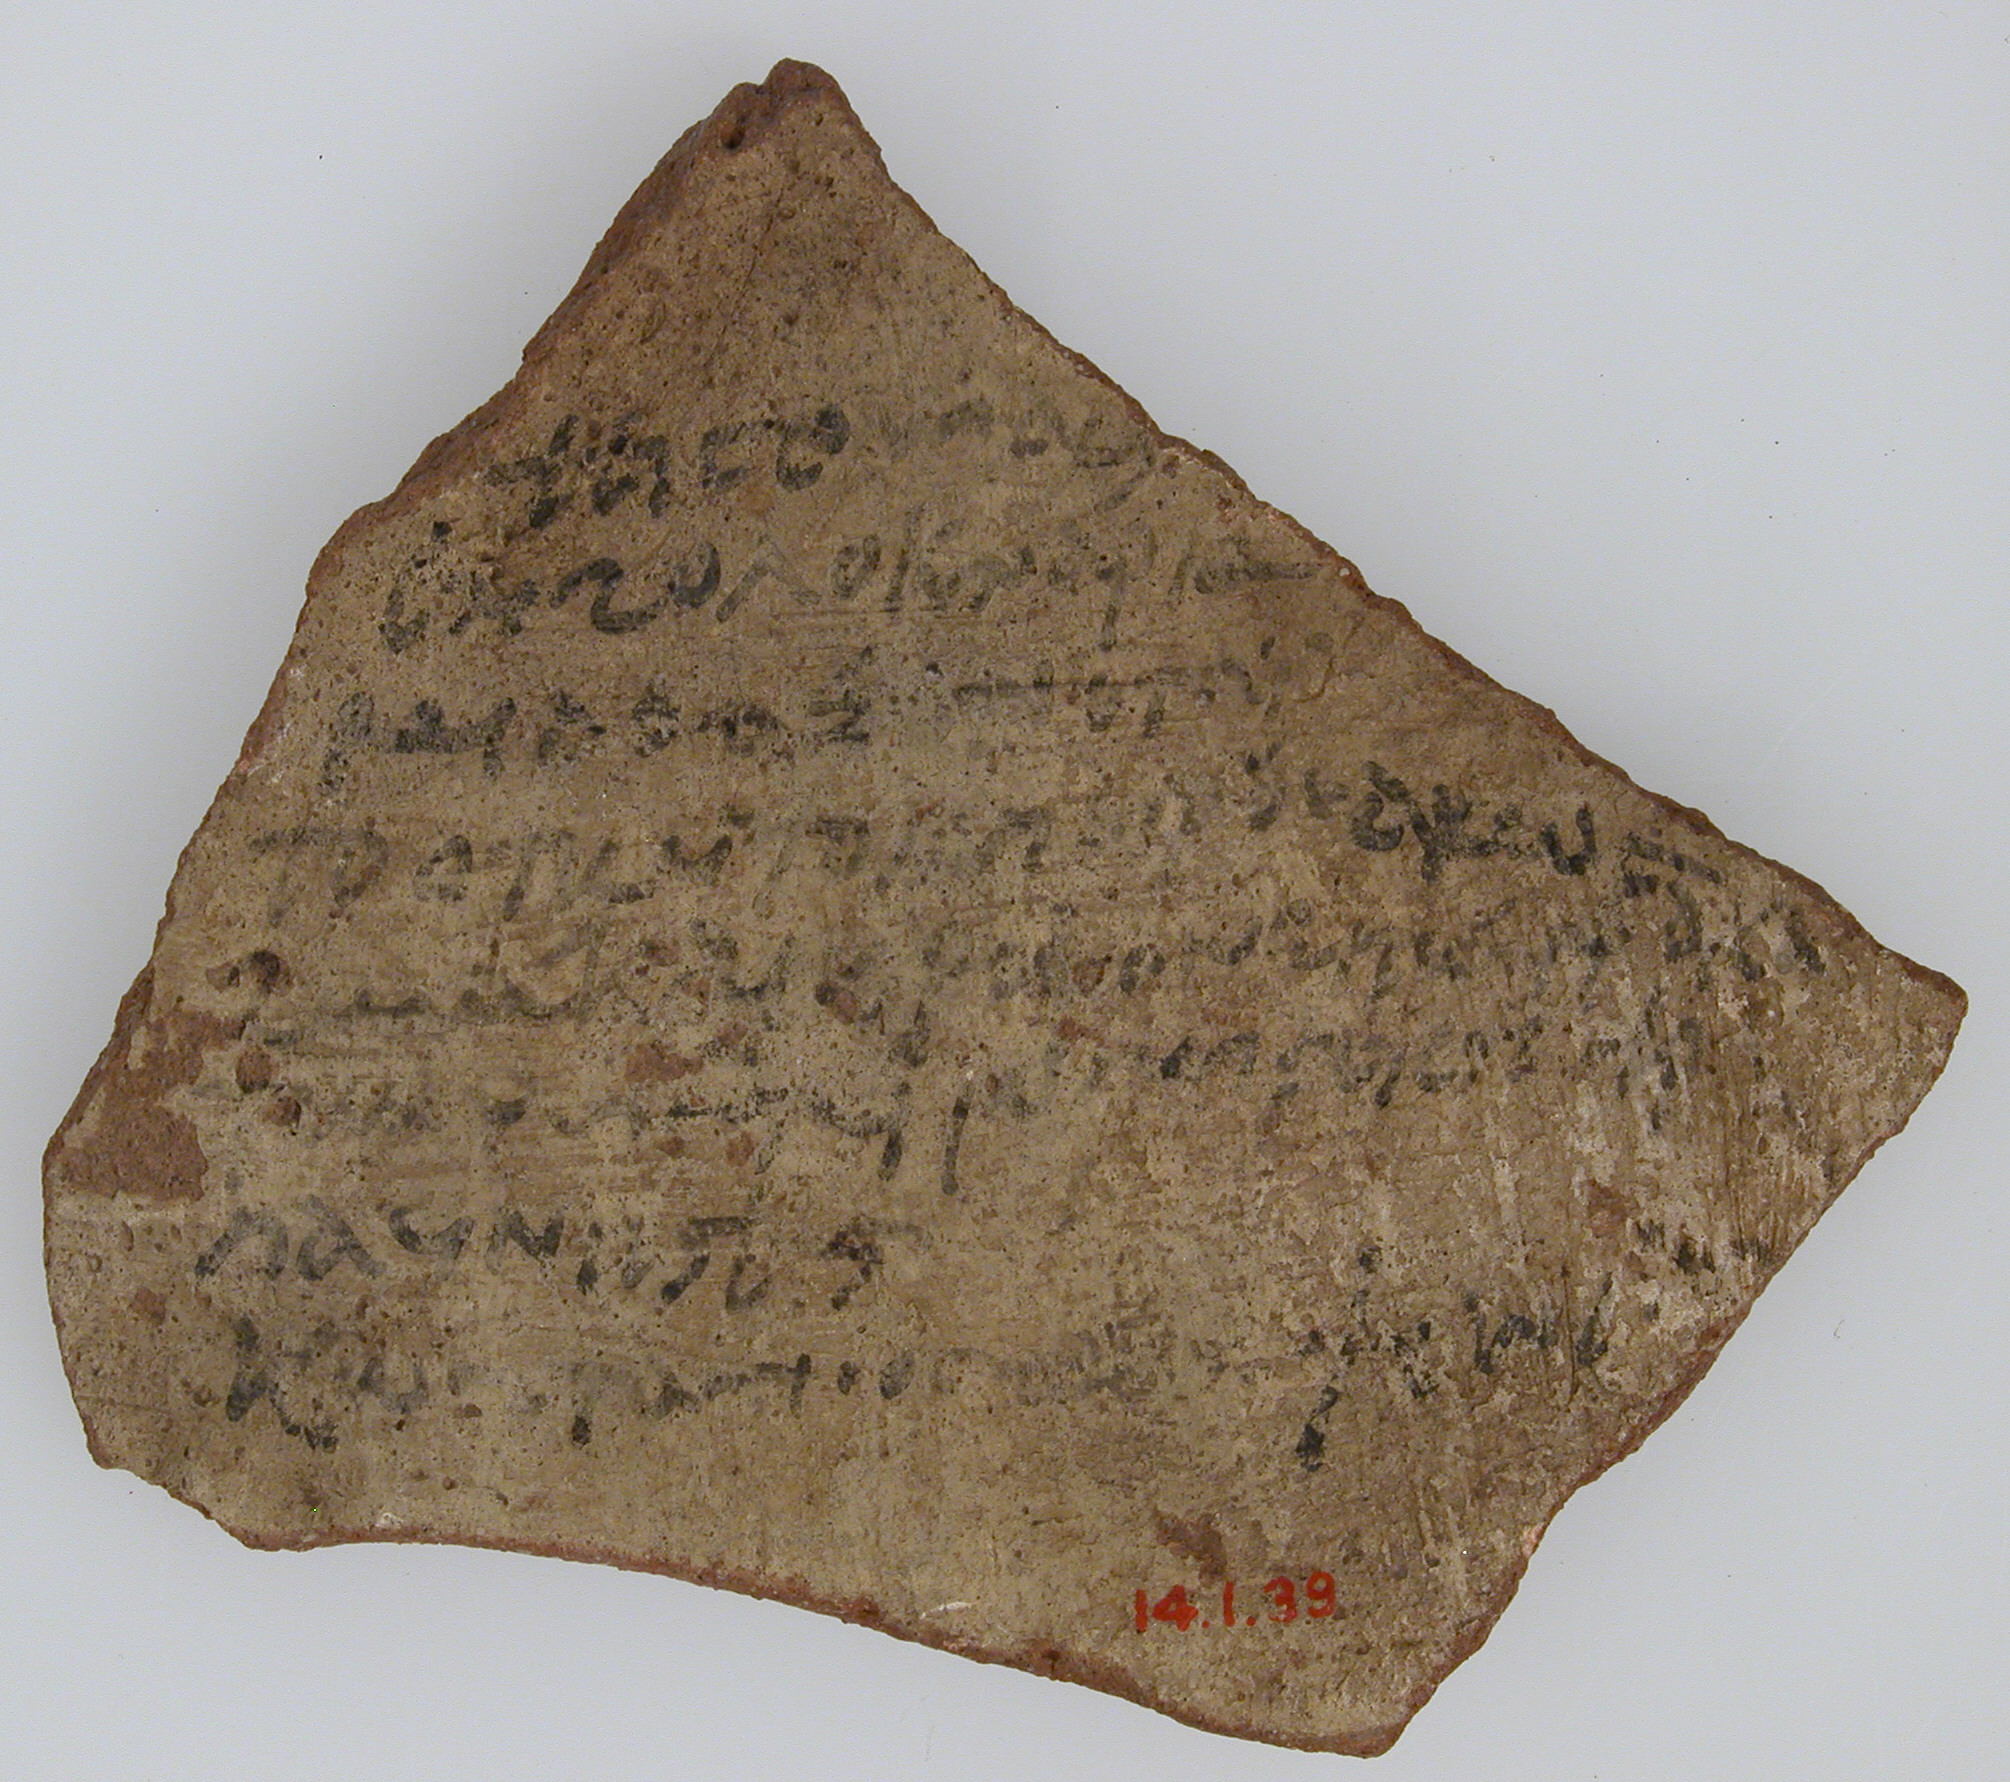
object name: ostrakon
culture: coptic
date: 600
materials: ink, pottery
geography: egypt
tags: coptic,documents